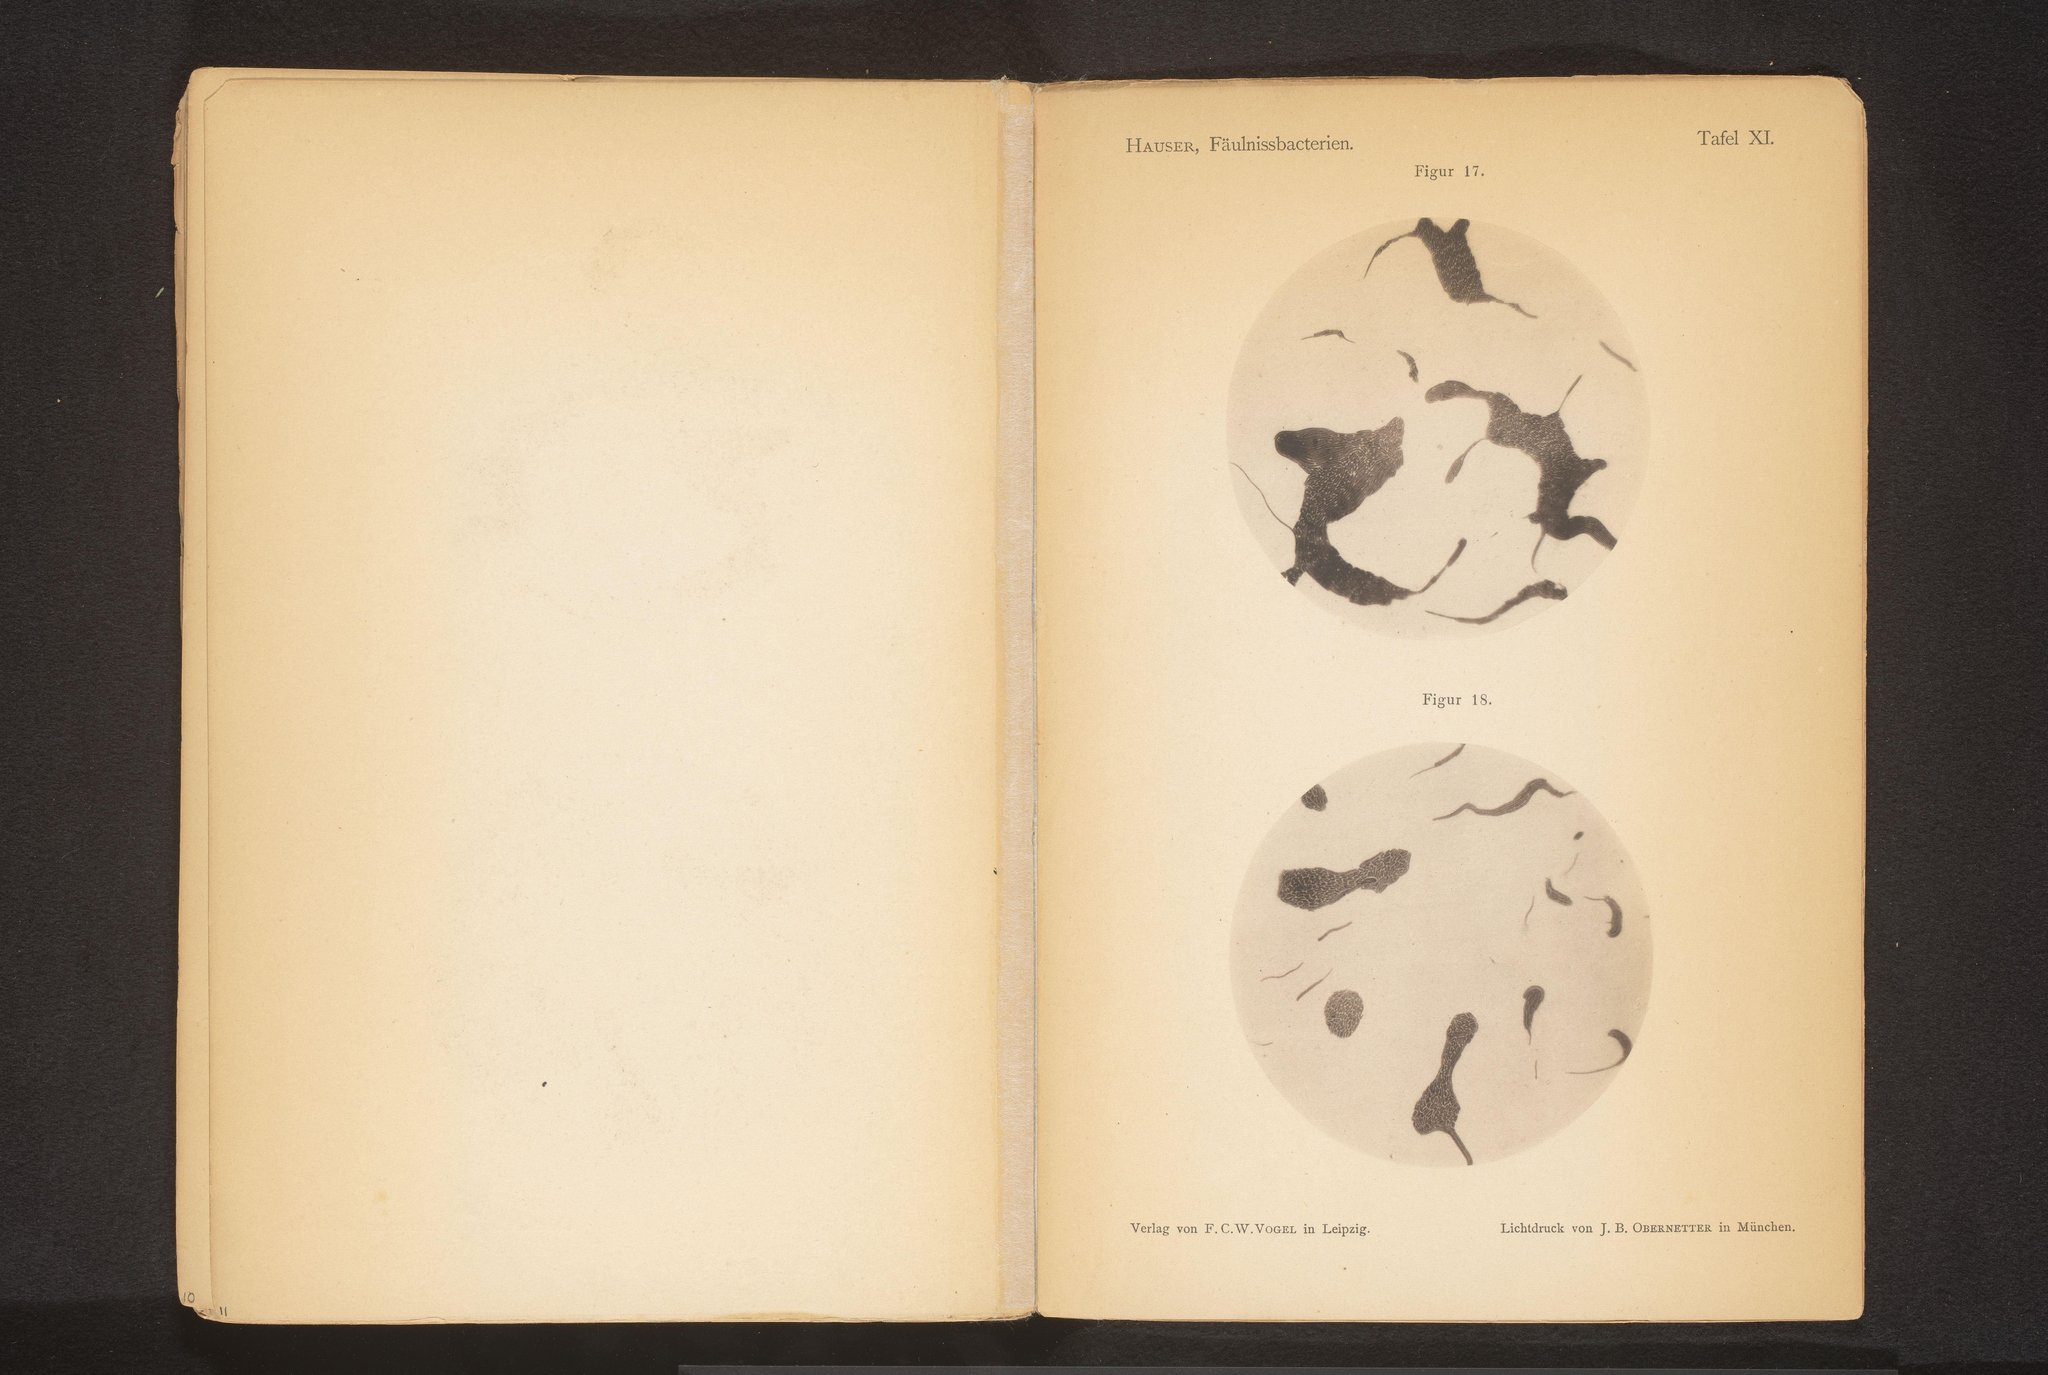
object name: photomechanical print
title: Twee microscoopopnamen van bederfbacteriën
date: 1875-1885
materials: paper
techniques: photograph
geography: munich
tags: unicellular animals, bacteria, bacilli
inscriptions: number: ‘Tafel XI. Figur 17. Figur 18.’